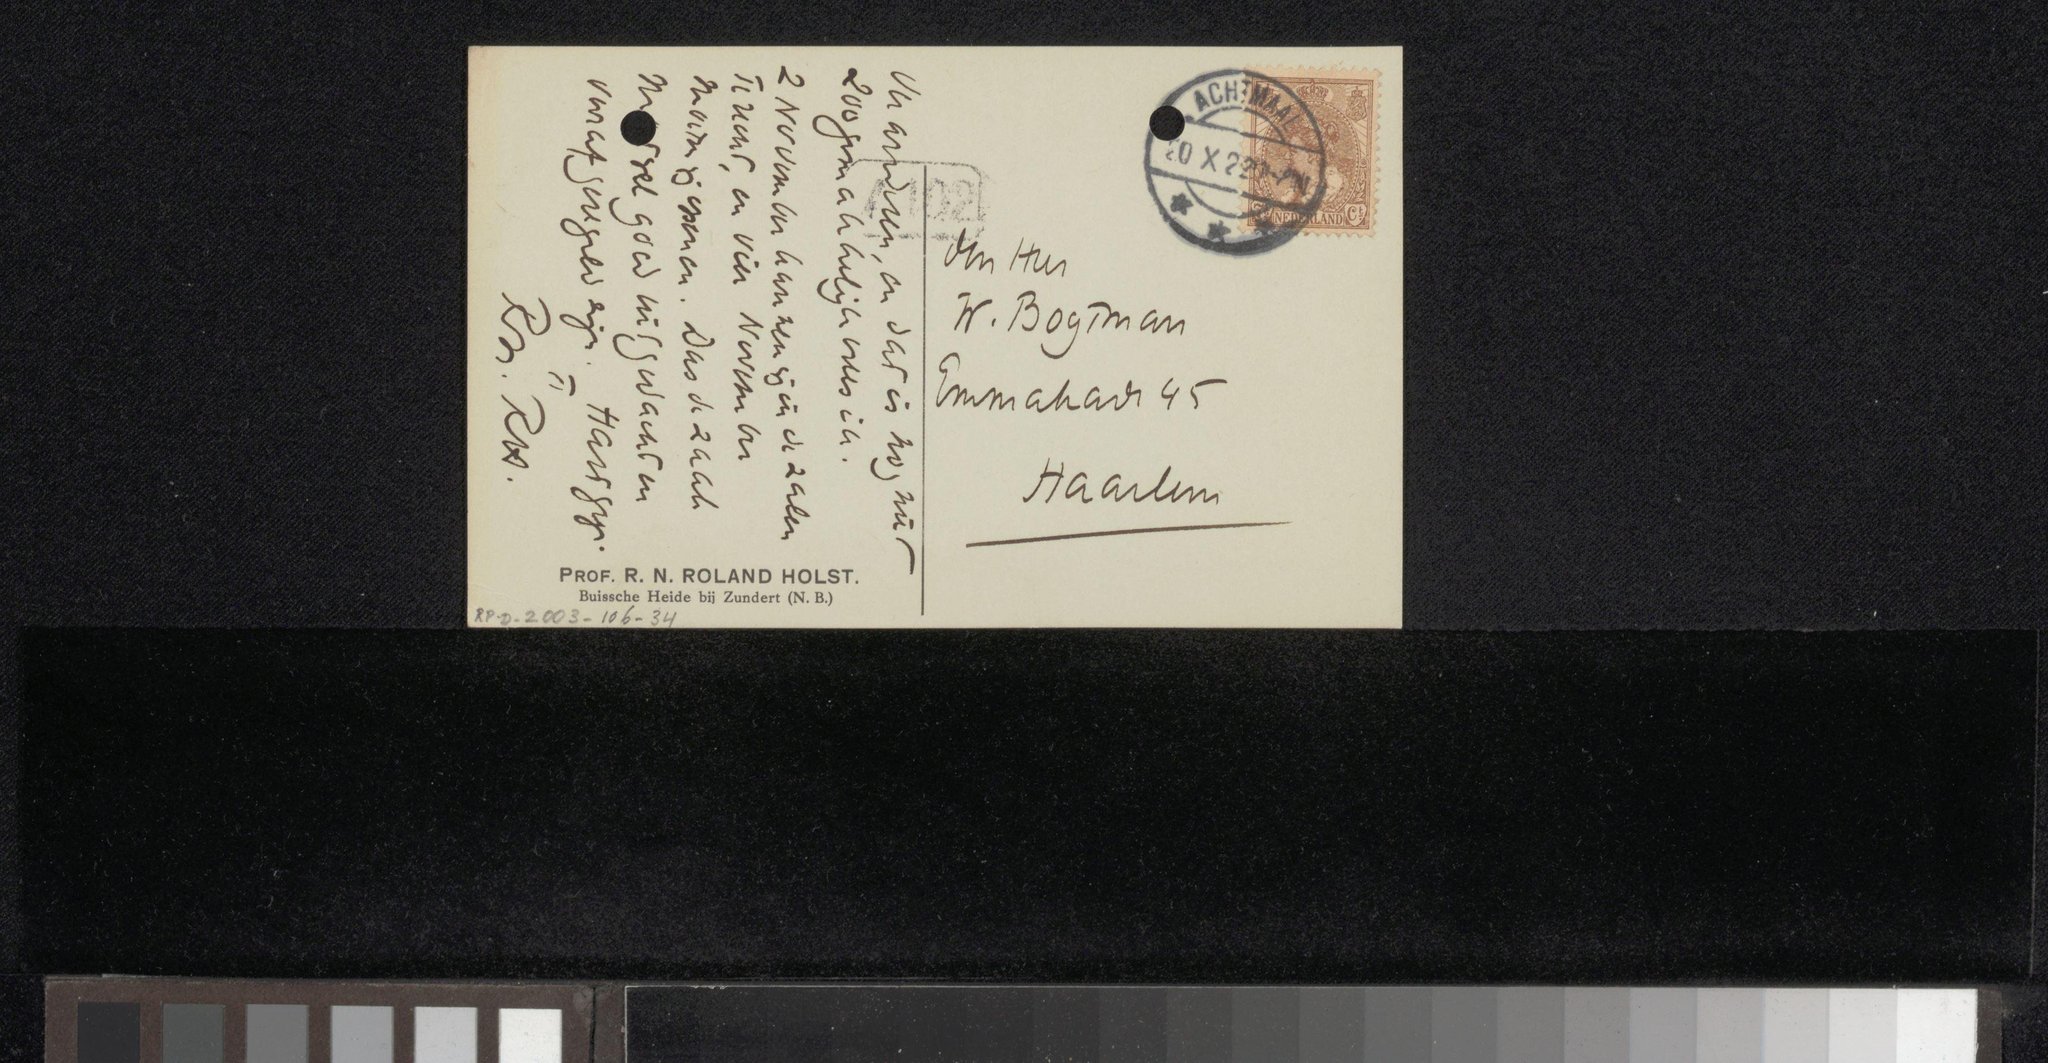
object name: postcard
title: Briefkaart aan Willem Bogtman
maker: richard nicolaüs roland holst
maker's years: 1868-1938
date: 1922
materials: cardboard, ink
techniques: pen, writing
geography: achtmaal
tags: haarlem, willem bogtman, applied arts, arts and crafts; industrial design, exhibition ~ art